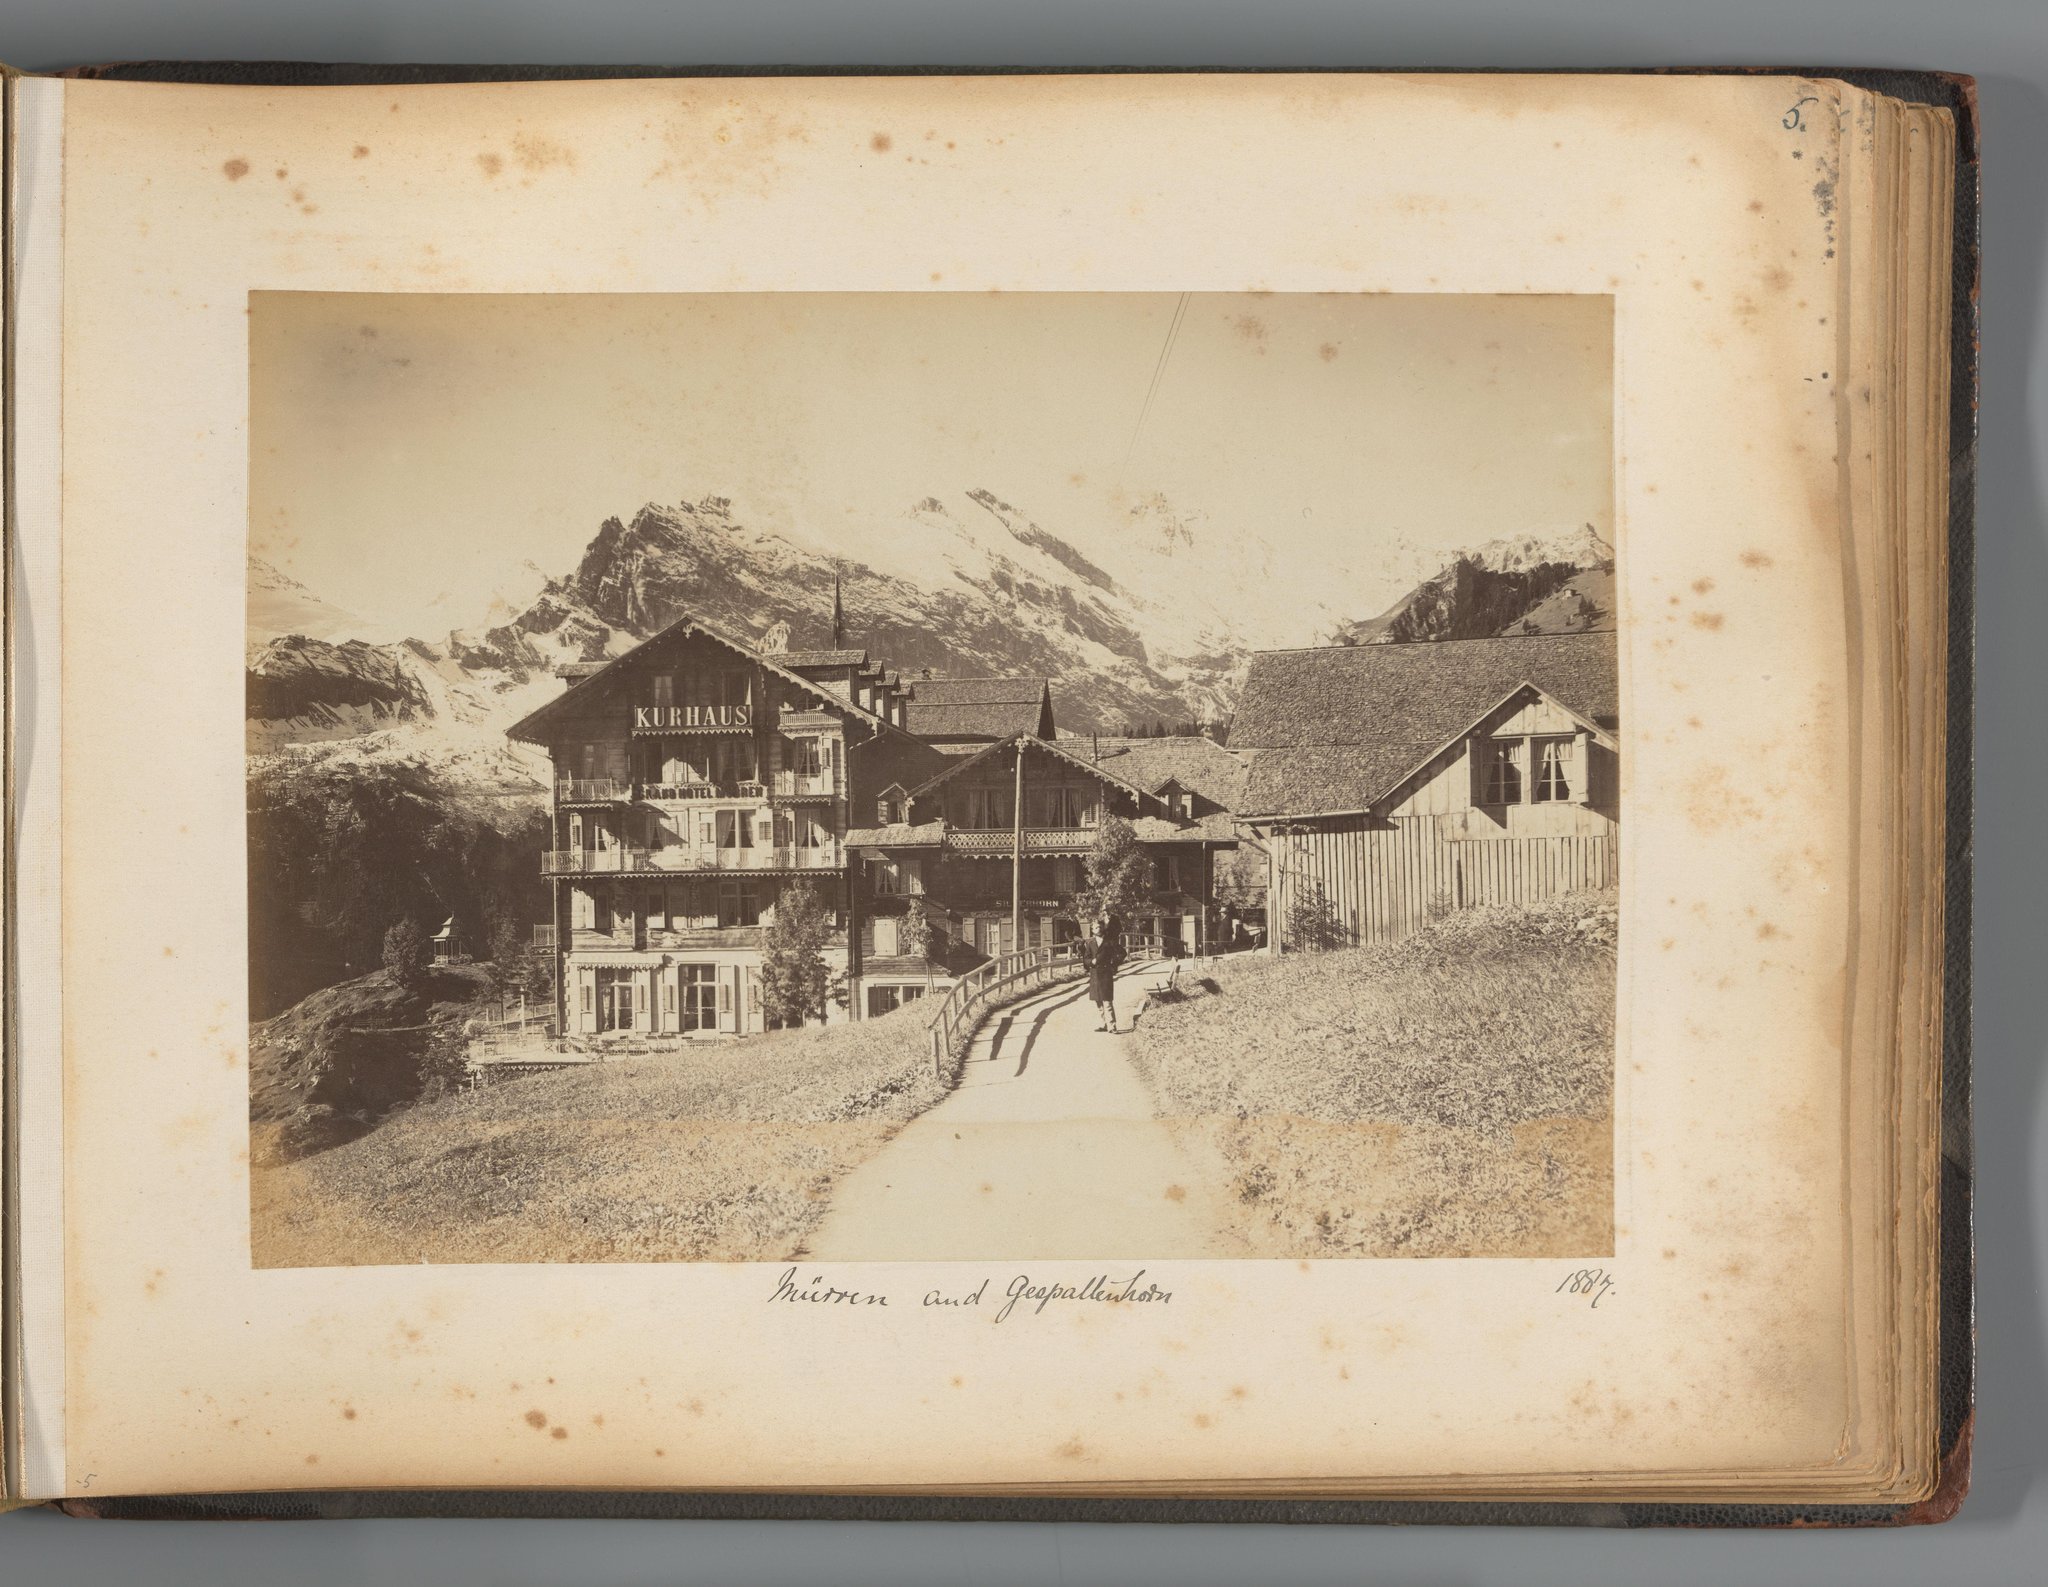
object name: photograph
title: Mürren and Gespallenhorn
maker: c.c. blackburn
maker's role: fotograaf, luitenant-kolonel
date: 1887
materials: paper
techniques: albumen print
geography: mürren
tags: watering-place, spa, mountains